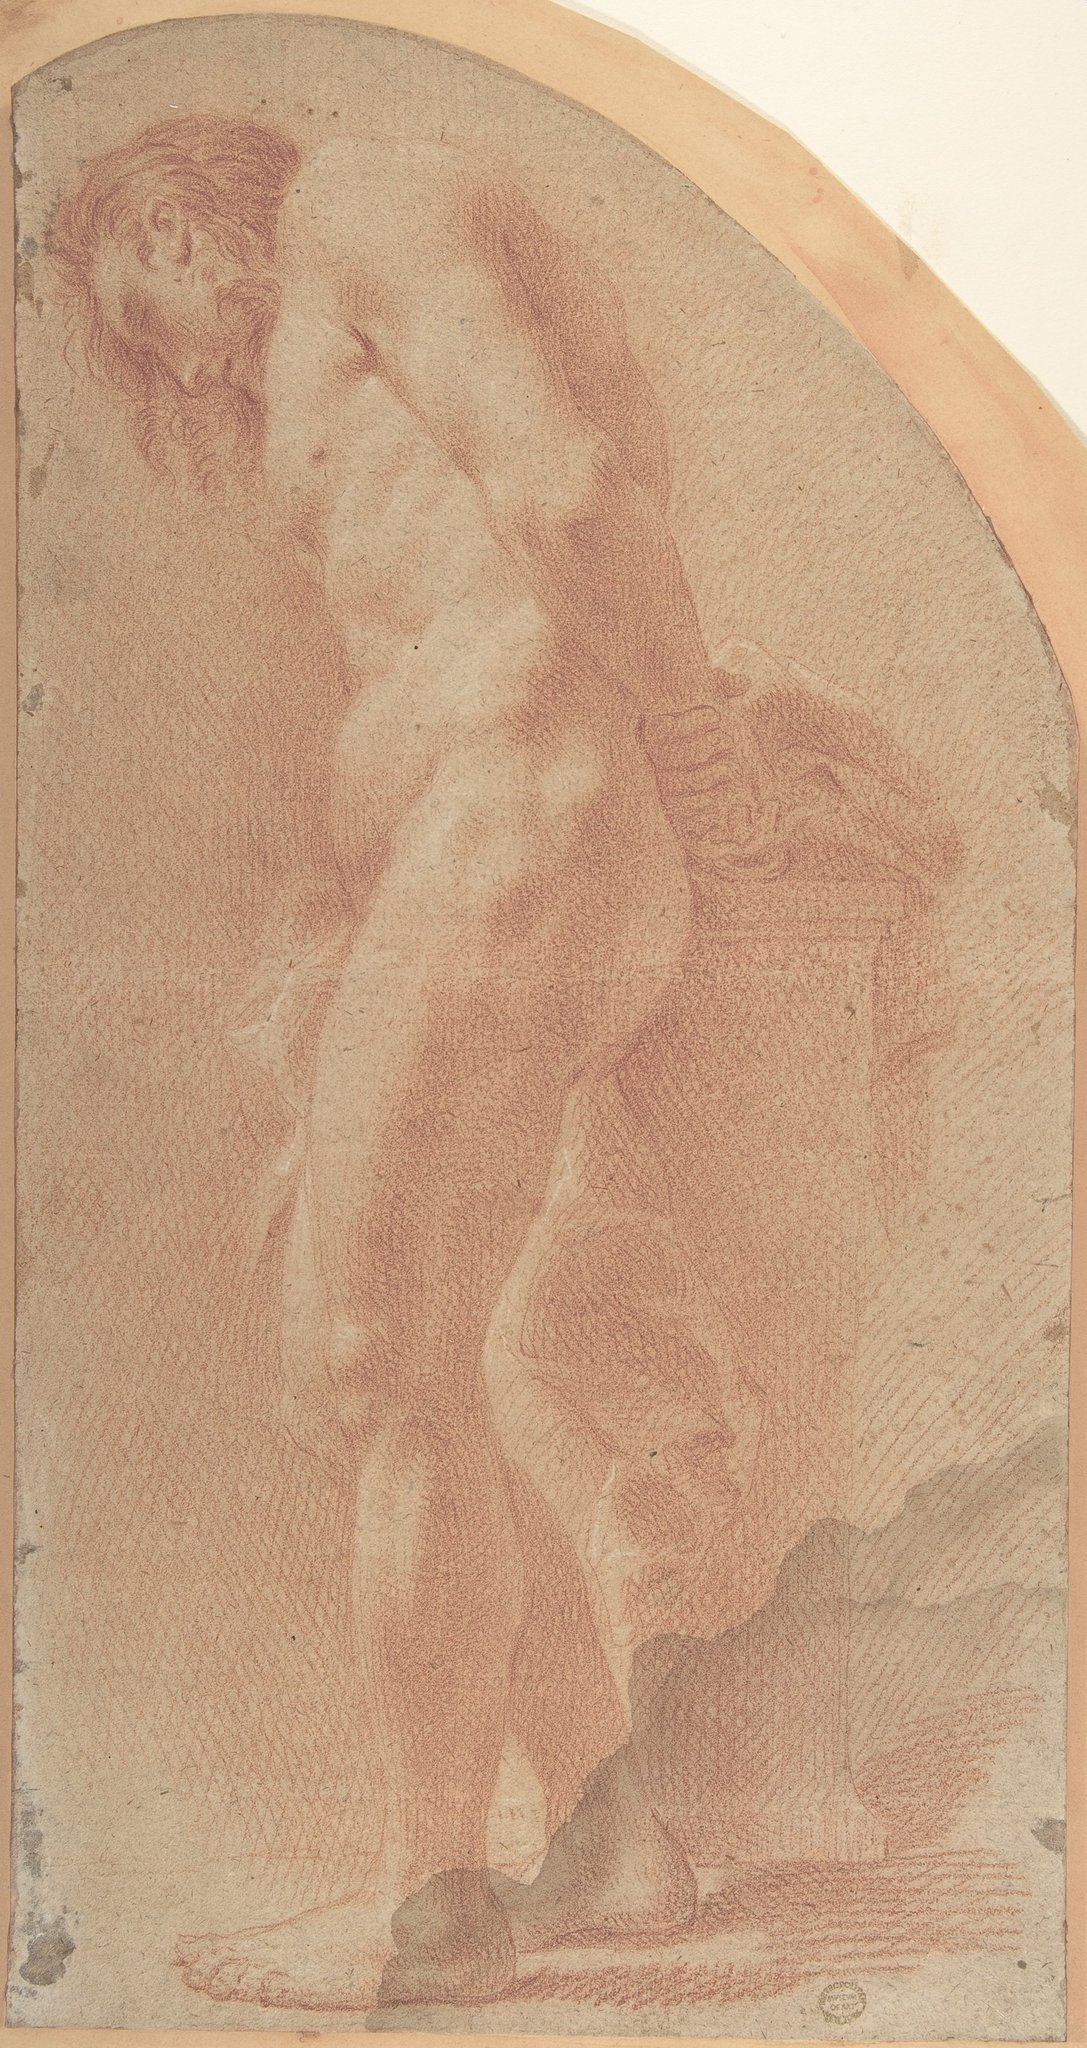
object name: drawing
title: Study of a Male Nude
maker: anonymous, italian, 18th century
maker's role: artist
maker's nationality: italian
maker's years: 1700-1800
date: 1701-1800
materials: chalk, paper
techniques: highlighting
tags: male nudes